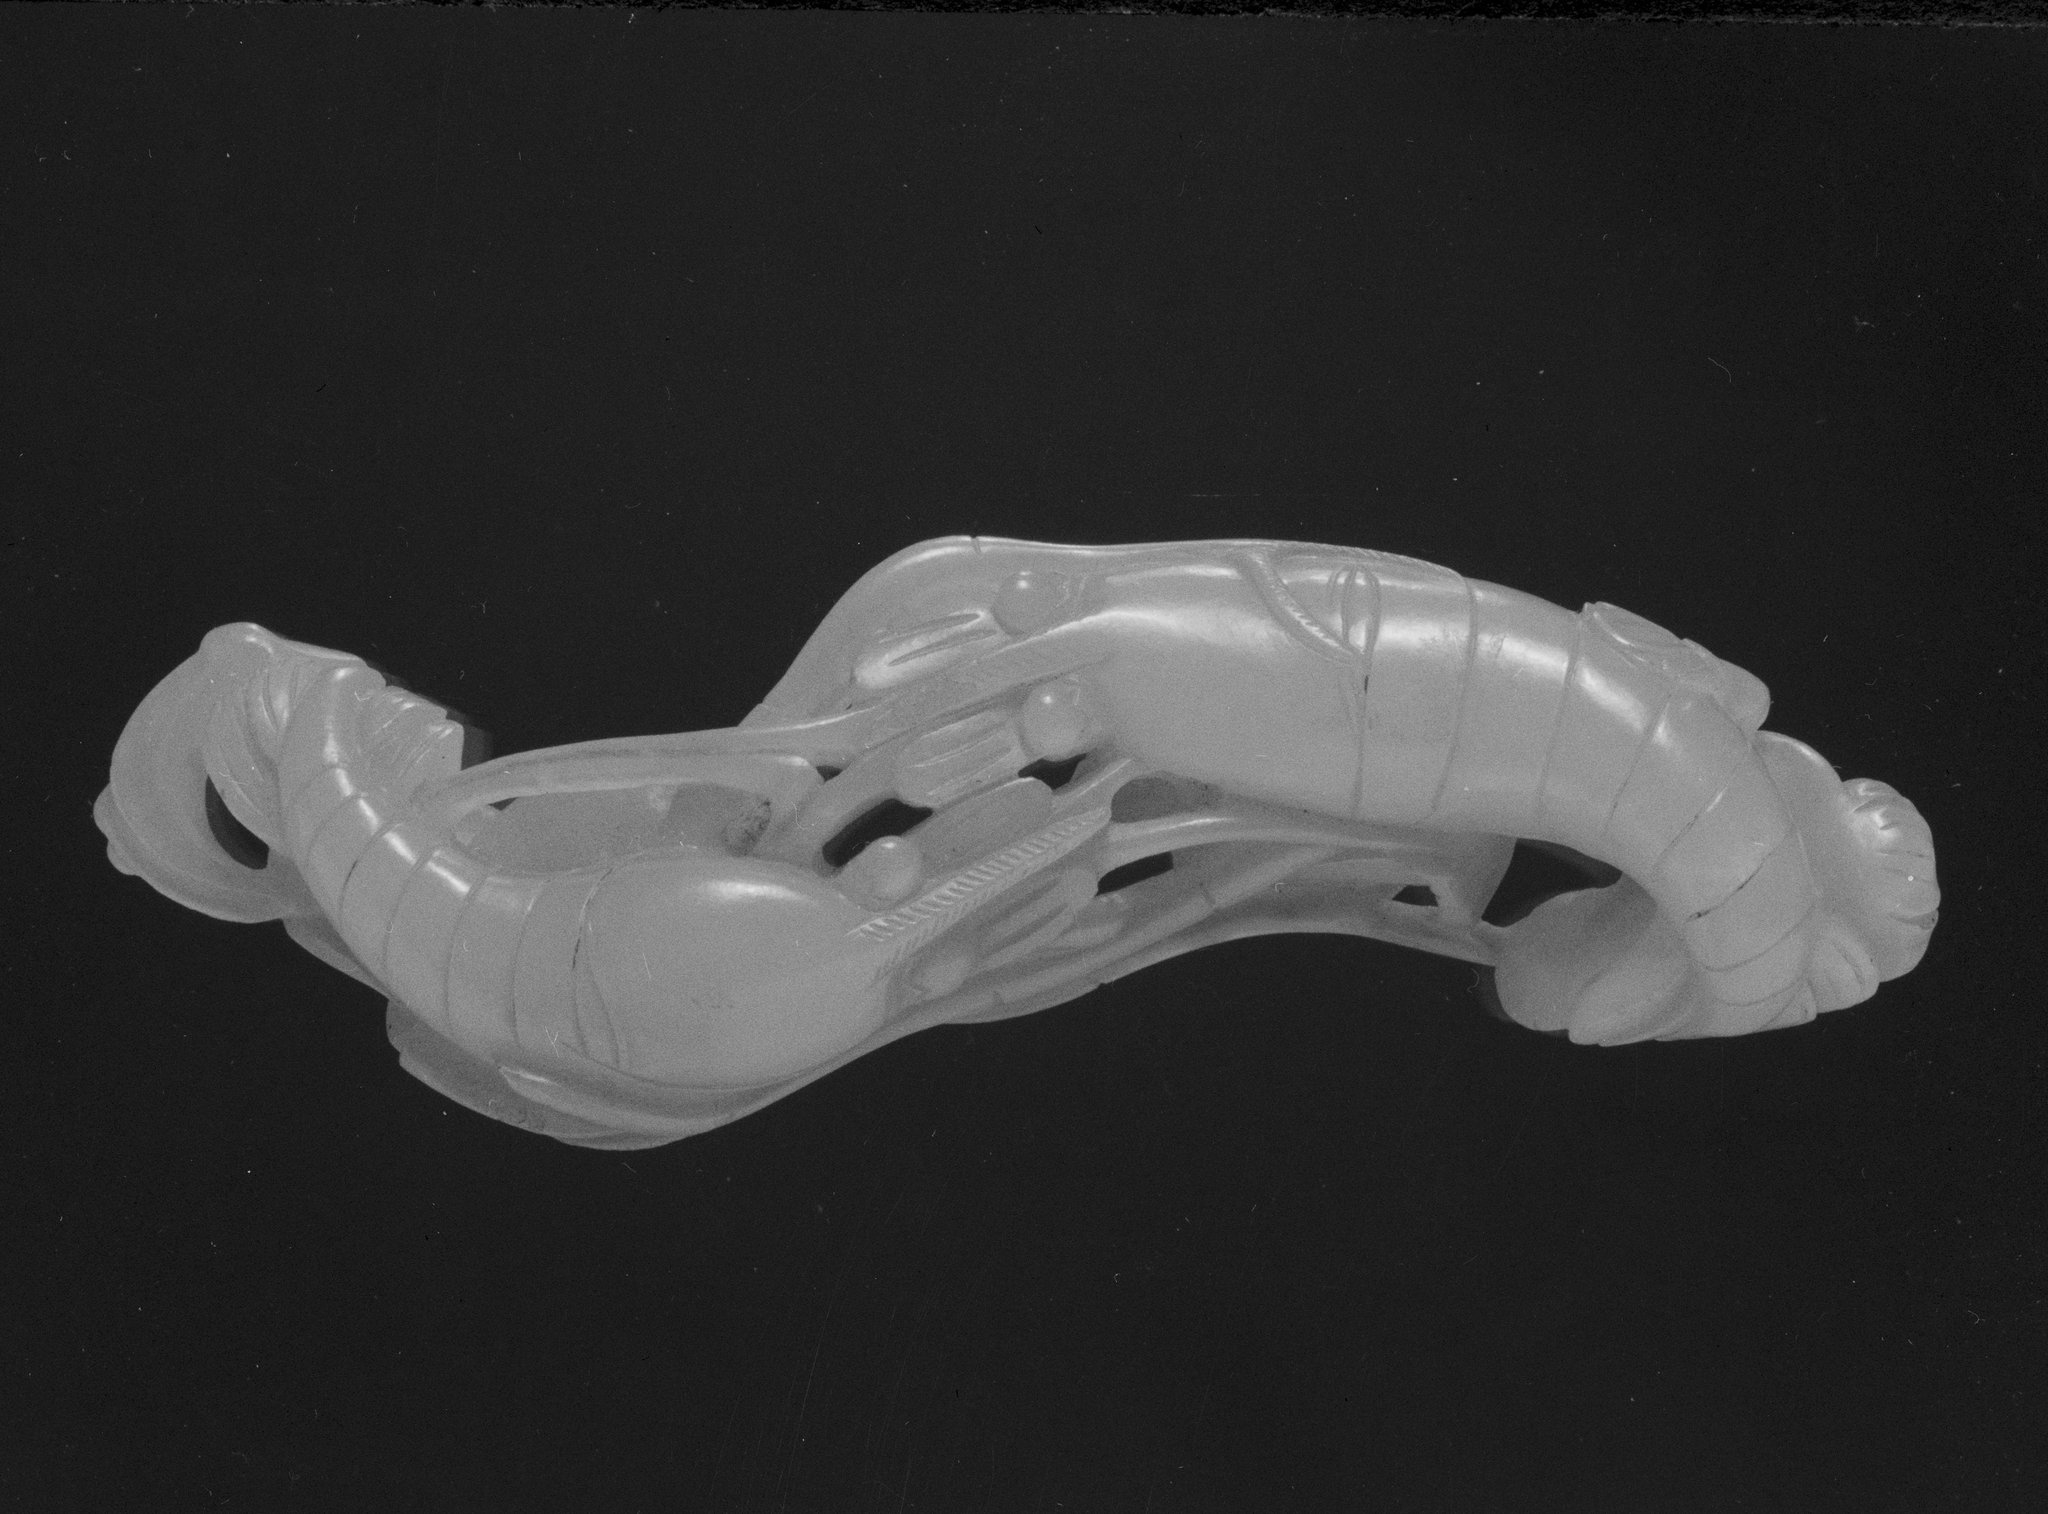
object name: toggle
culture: chinese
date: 1701-1800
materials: jade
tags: lobsters